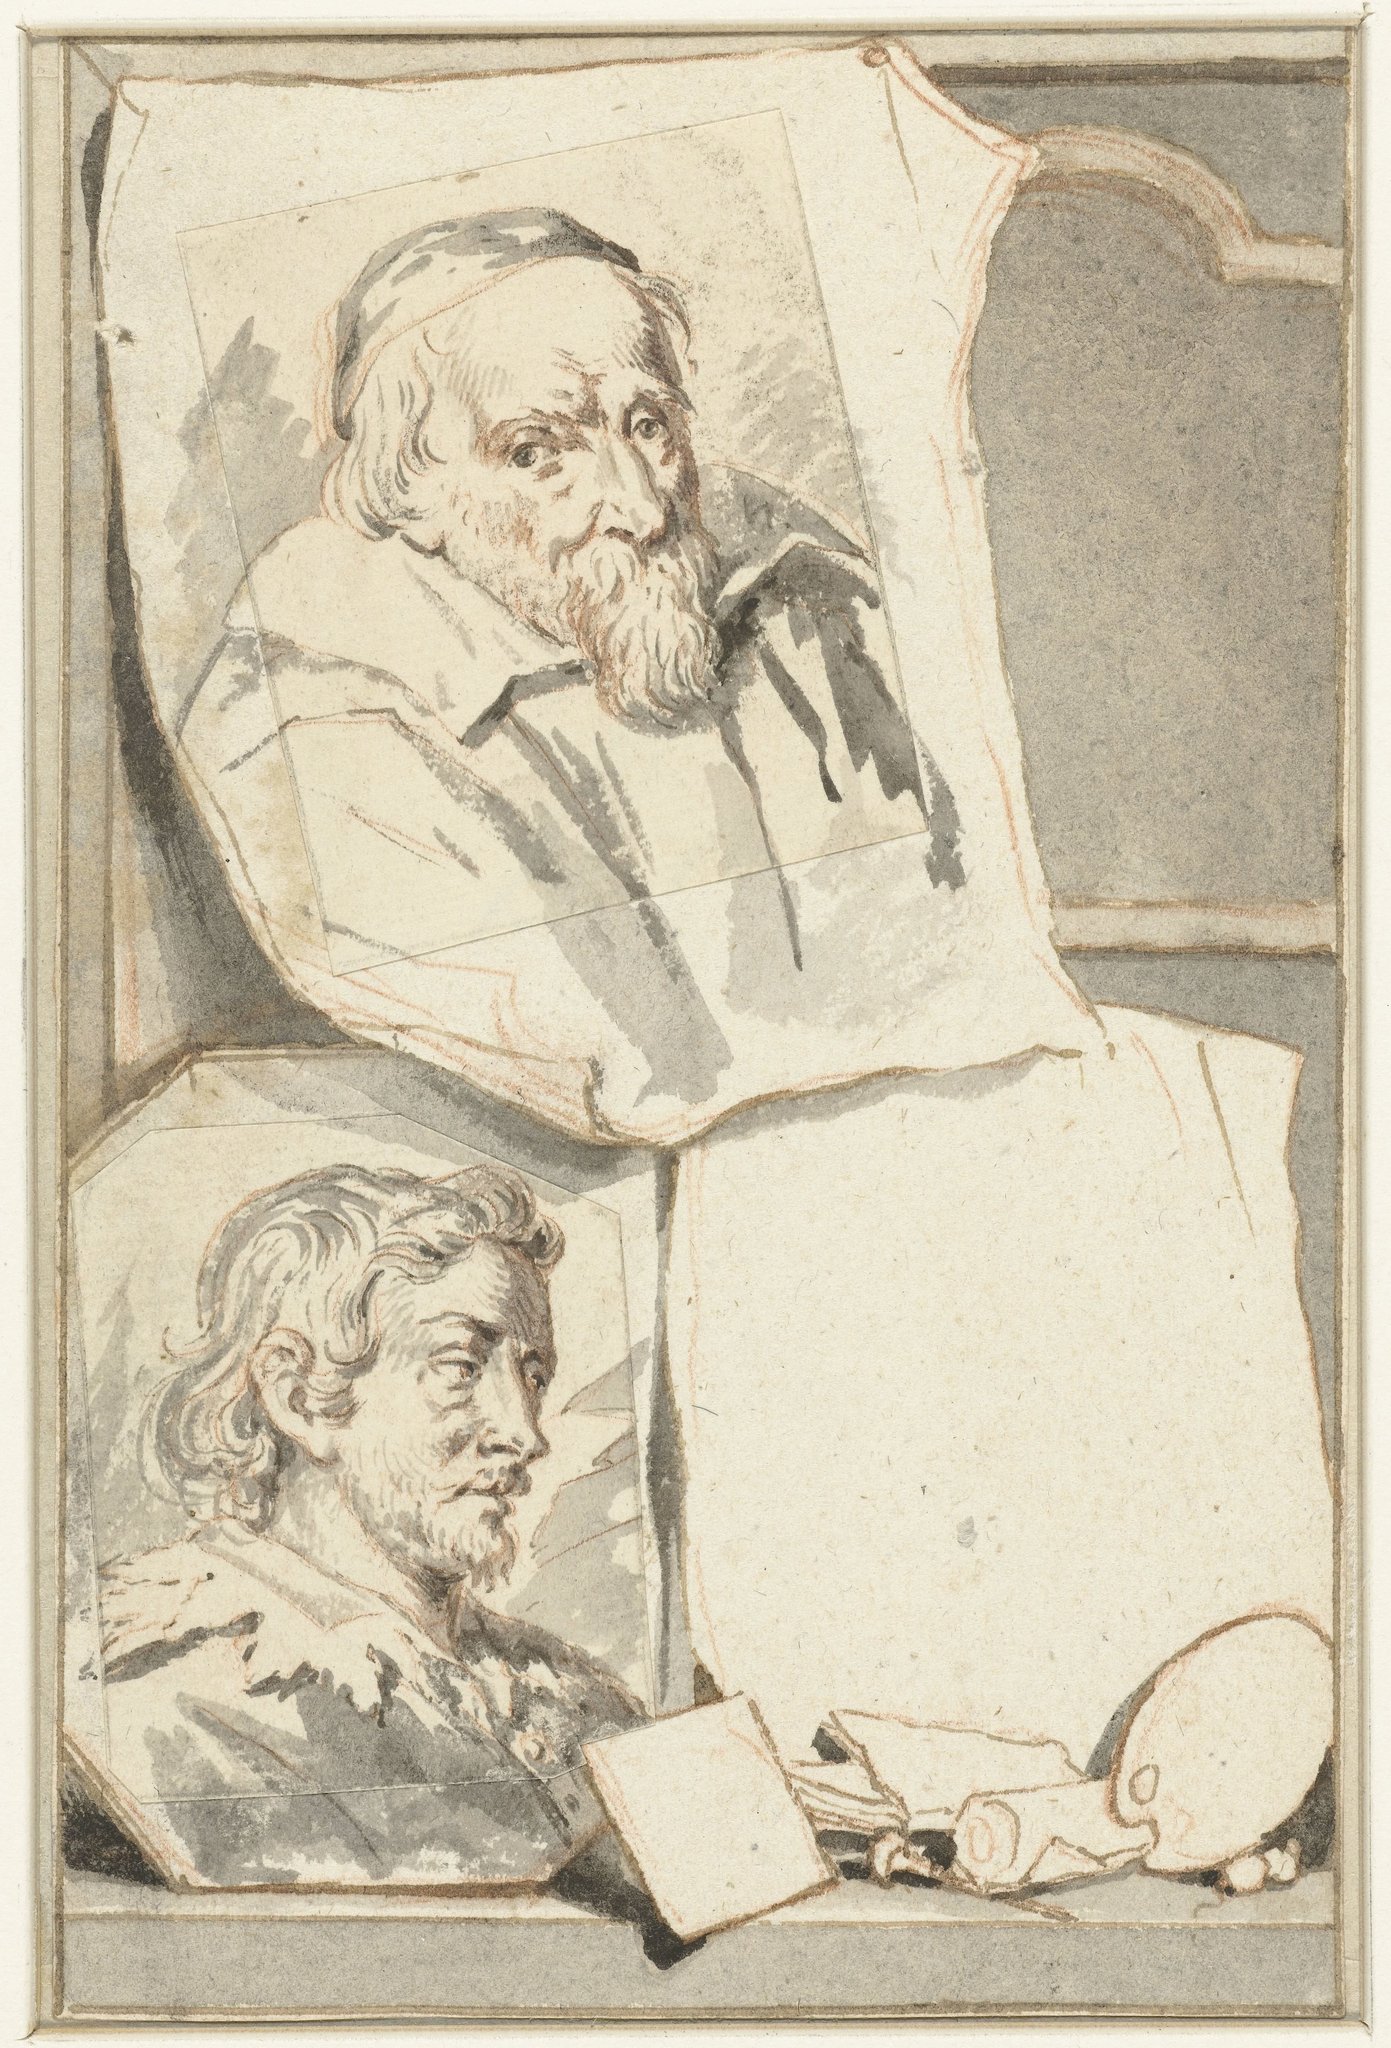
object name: design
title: Portretten van Wencelaus Koeberger en Lucas van Uden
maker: jacob houbraken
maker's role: draughtsman, print maker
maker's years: 1698-1780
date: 1708-1780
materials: chalk, ink, paper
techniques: brush, pen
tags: antwerp, brussels, draughtsman, wenzel coebergher, lucas van uden, historical persons, portrait, self-portrait of painter, portrait, self-portrait of artist